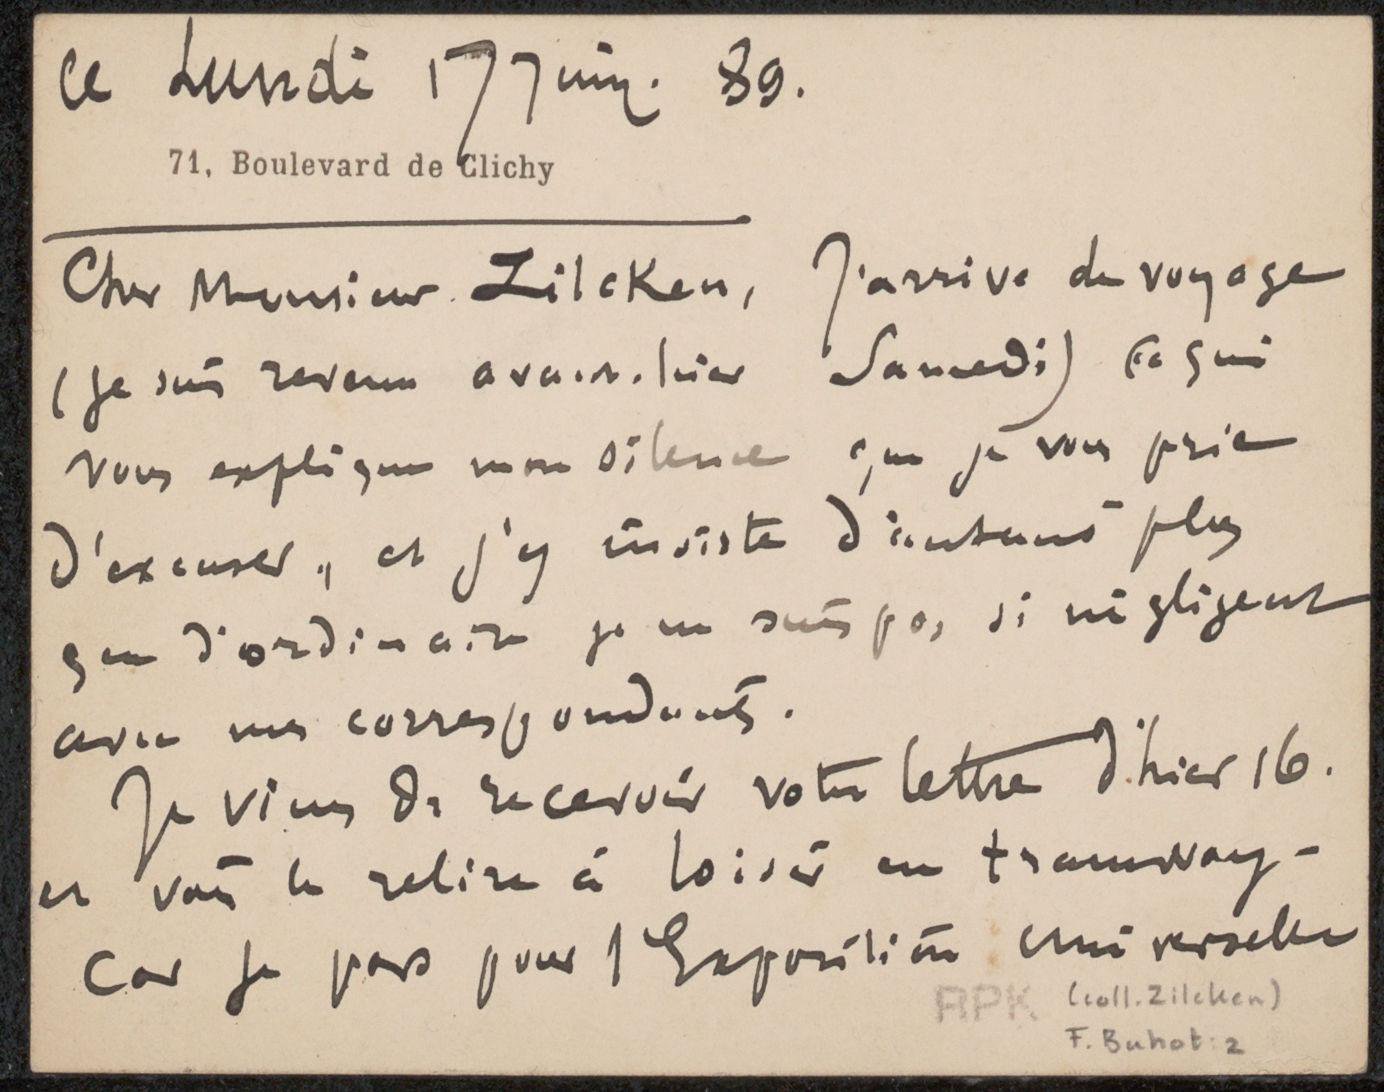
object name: letter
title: Brief aan Philip Zilcken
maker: félix hilaire buhot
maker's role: draughtsman, print maker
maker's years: 1847-1898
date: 1889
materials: cardboard, ink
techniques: pen, writing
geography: paris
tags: paris, aglaüs bouvenne, print maker, charles albert waltner, rodolphe bresdin, the hague, philip zilcken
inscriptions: collector's mark: ‘RPK’